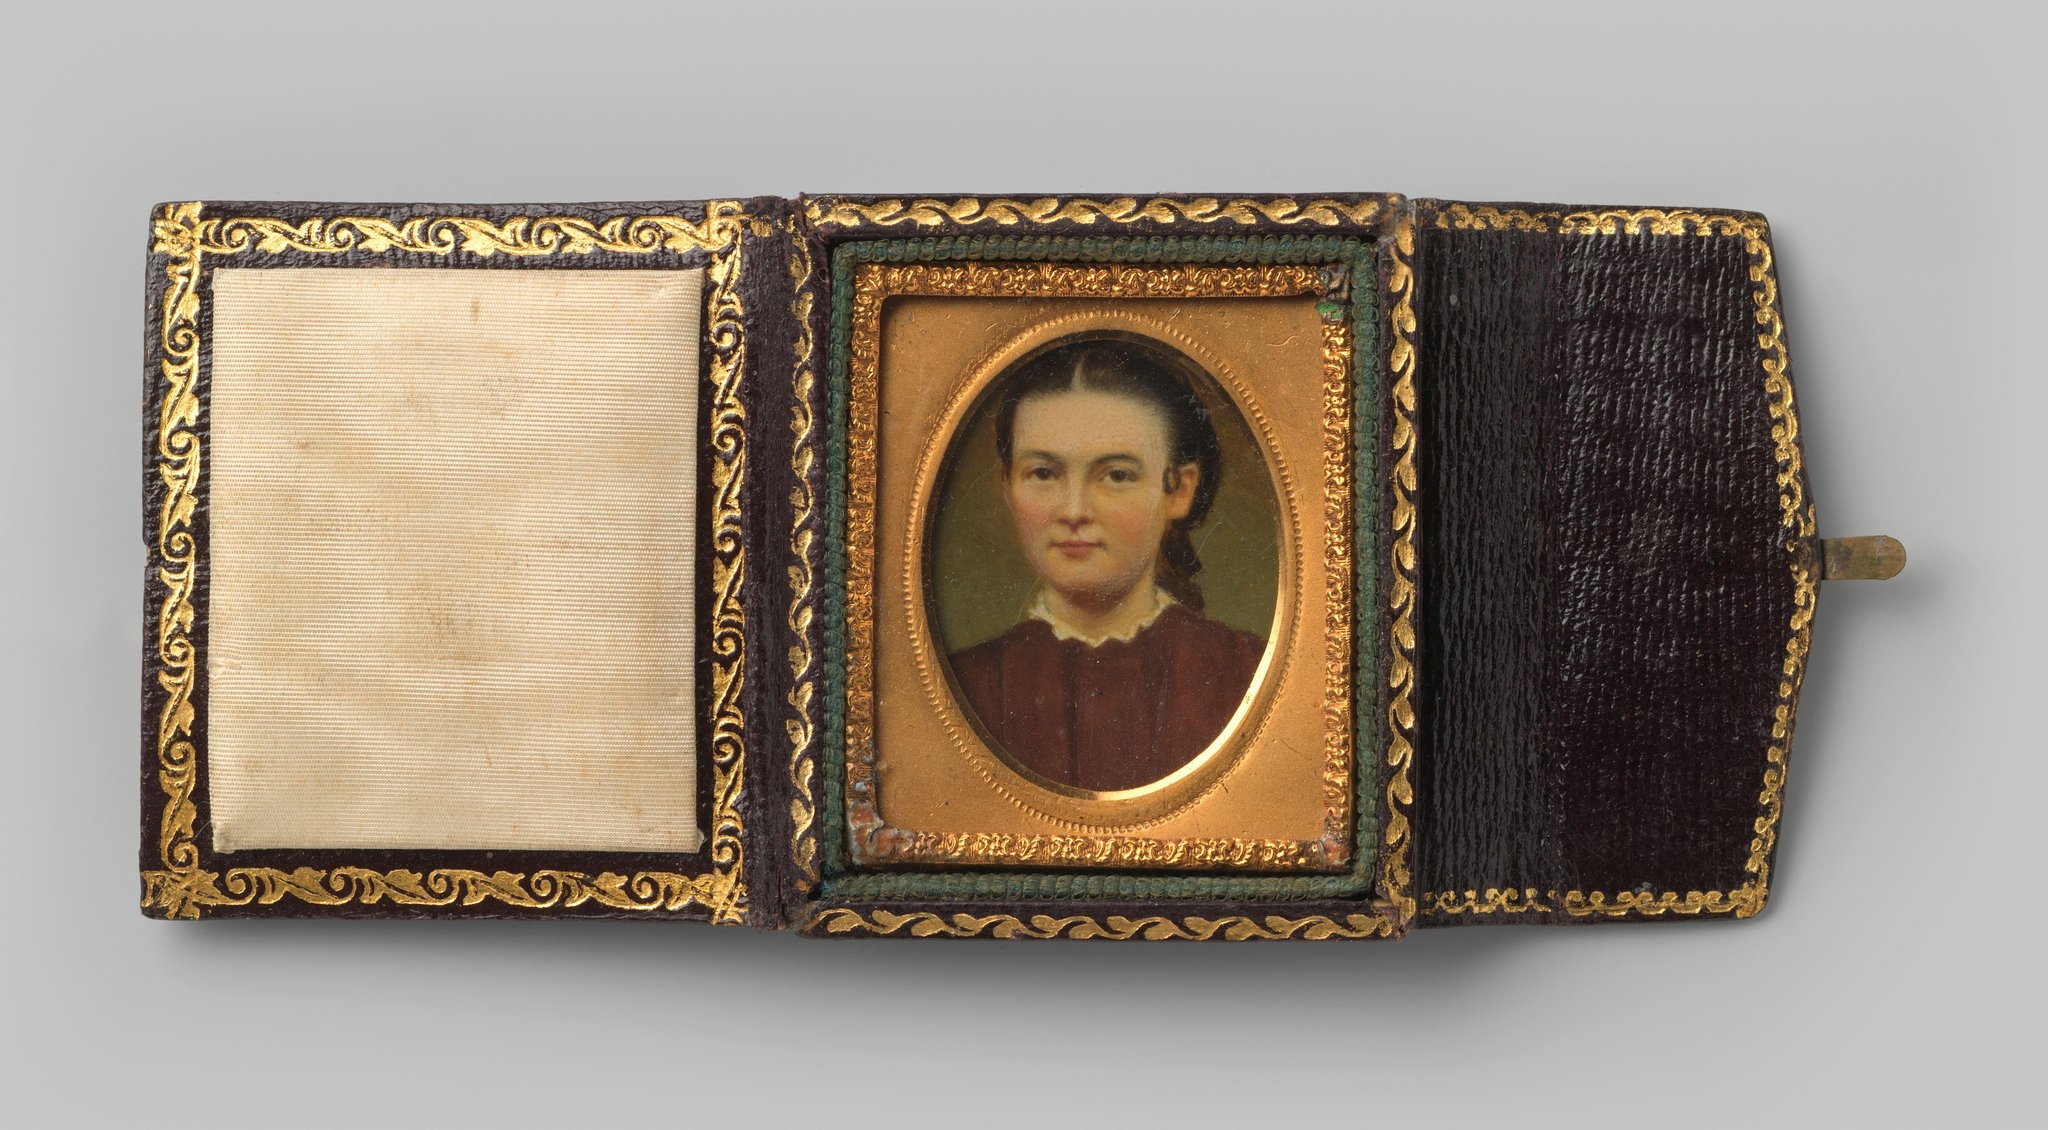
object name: photograph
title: Portret van een onbekende vrouw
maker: Anonymous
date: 1880-1900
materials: glass, leather, metal, paint, paper, textile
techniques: albumen print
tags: anonymous historical person portrayed - bb - woman